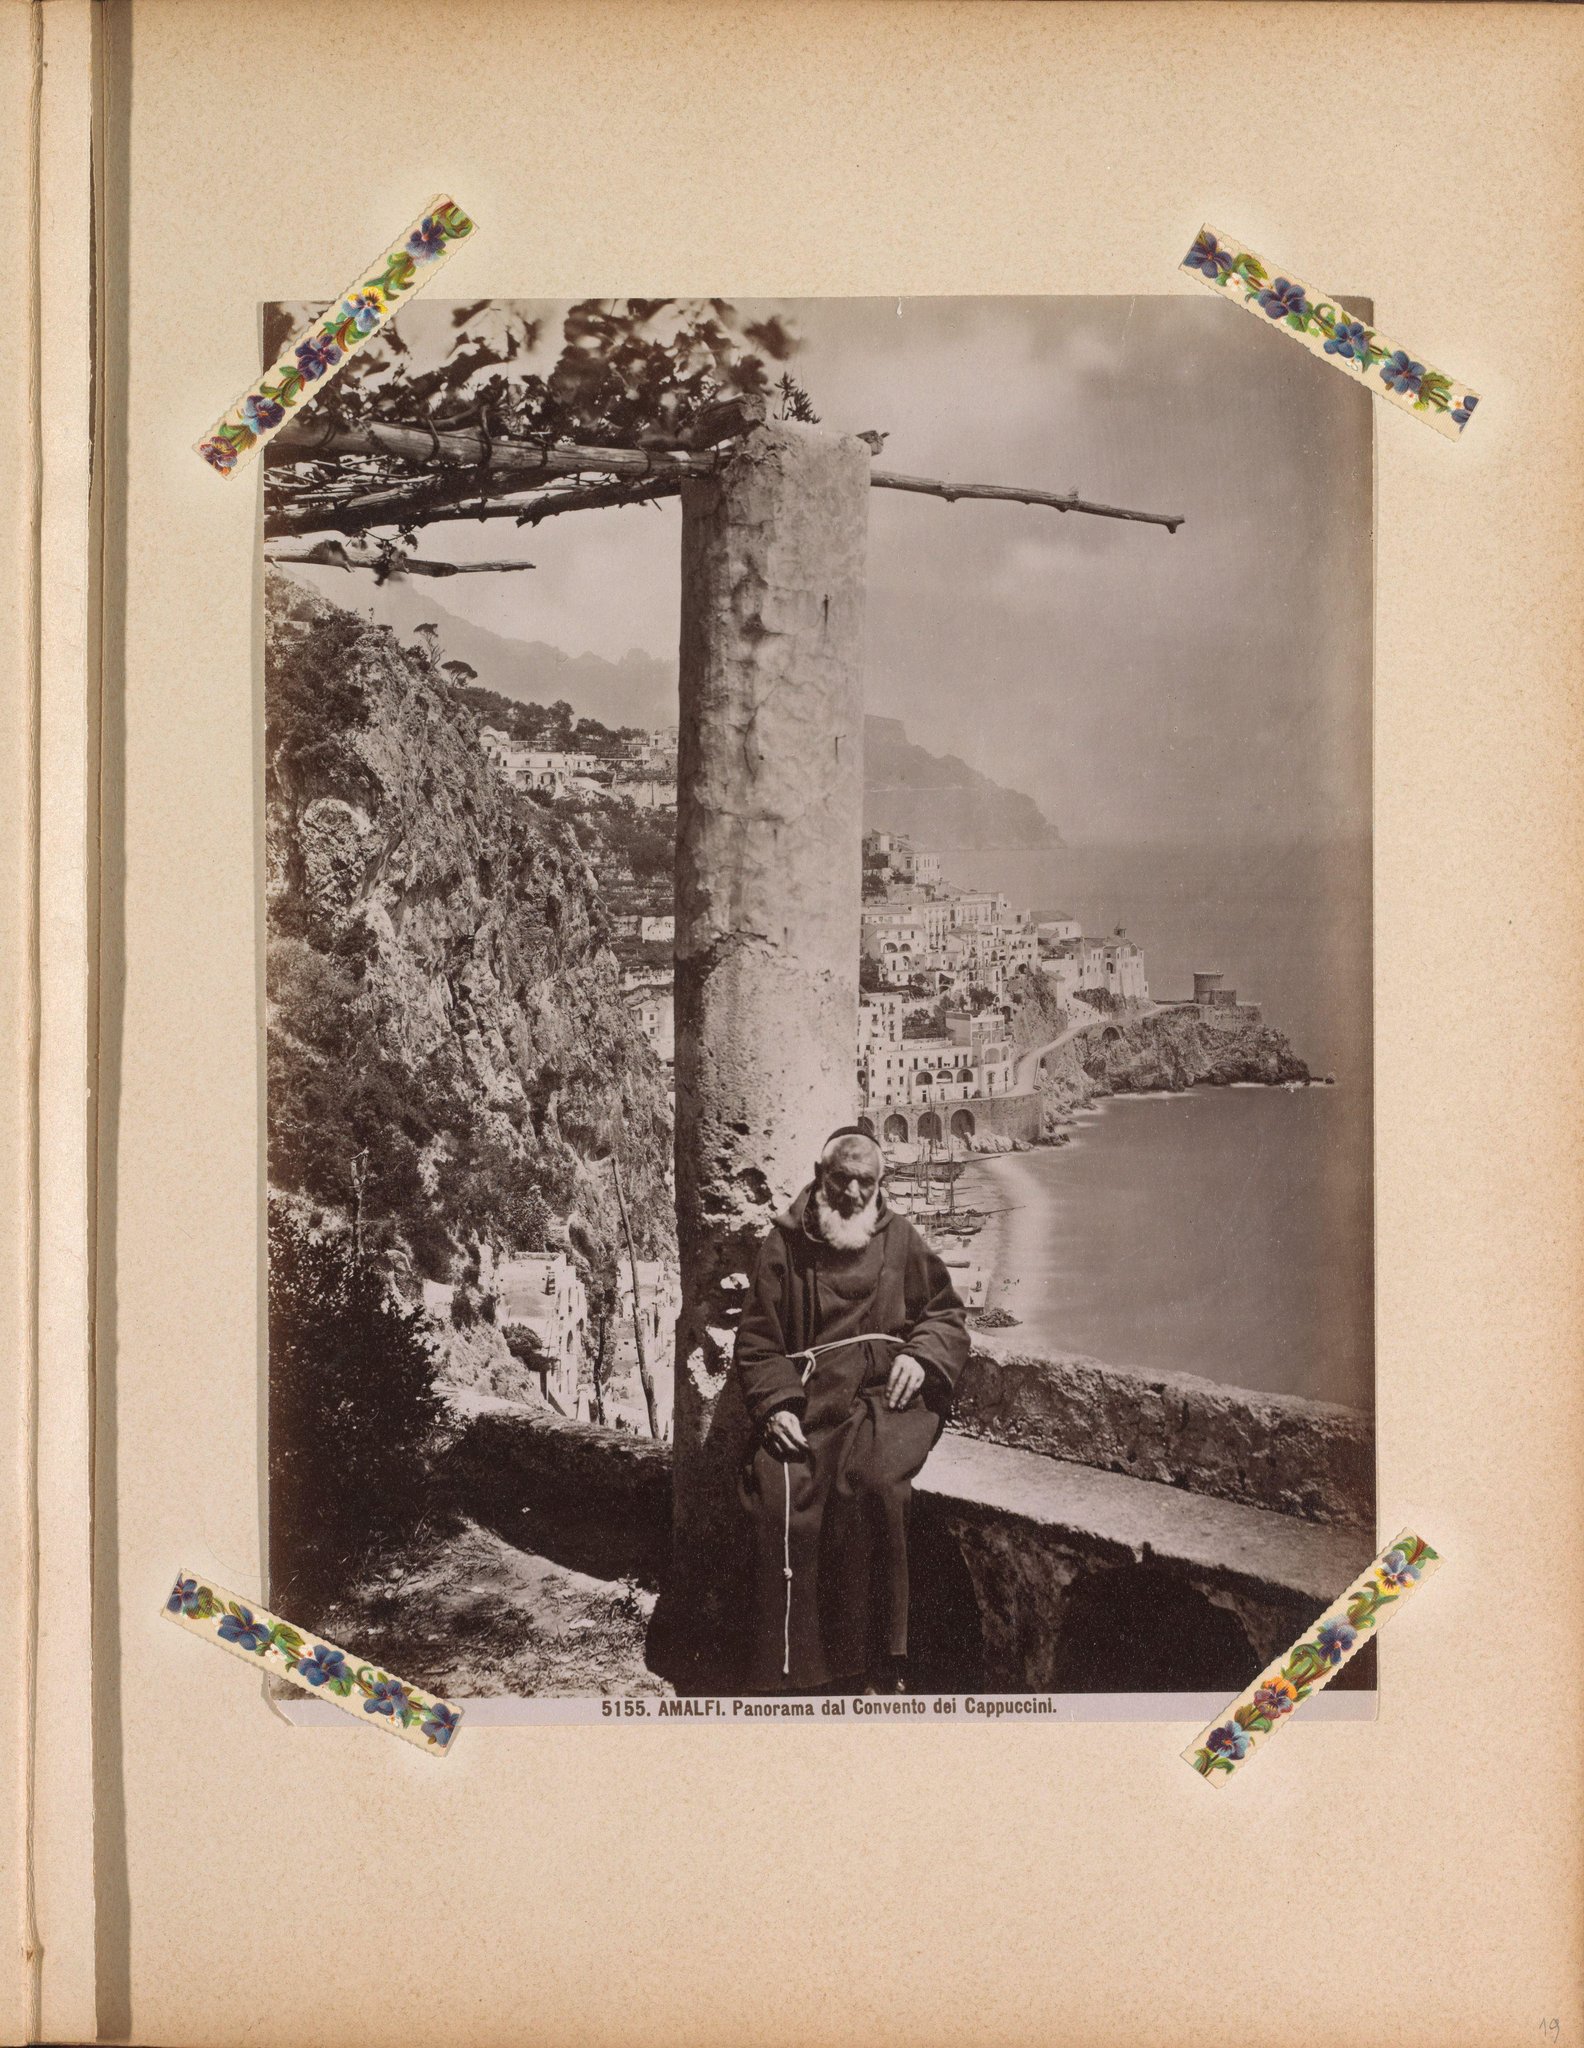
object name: album leaf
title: Gezicht op Amalfi vanuit een klooster, op de voorgrond een kapucijnermonnik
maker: Anonymous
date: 1870-1900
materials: paper, photographic support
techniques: albumen print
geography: amalfi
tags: prospect of village, silhouette of village, monk(s), friar(s), amalfi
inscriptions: negative number: ‘5155’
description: Onderdeel van Reisalbum met foto's van bezienswaardigheden in Italië en Zuid-Frankrijk.